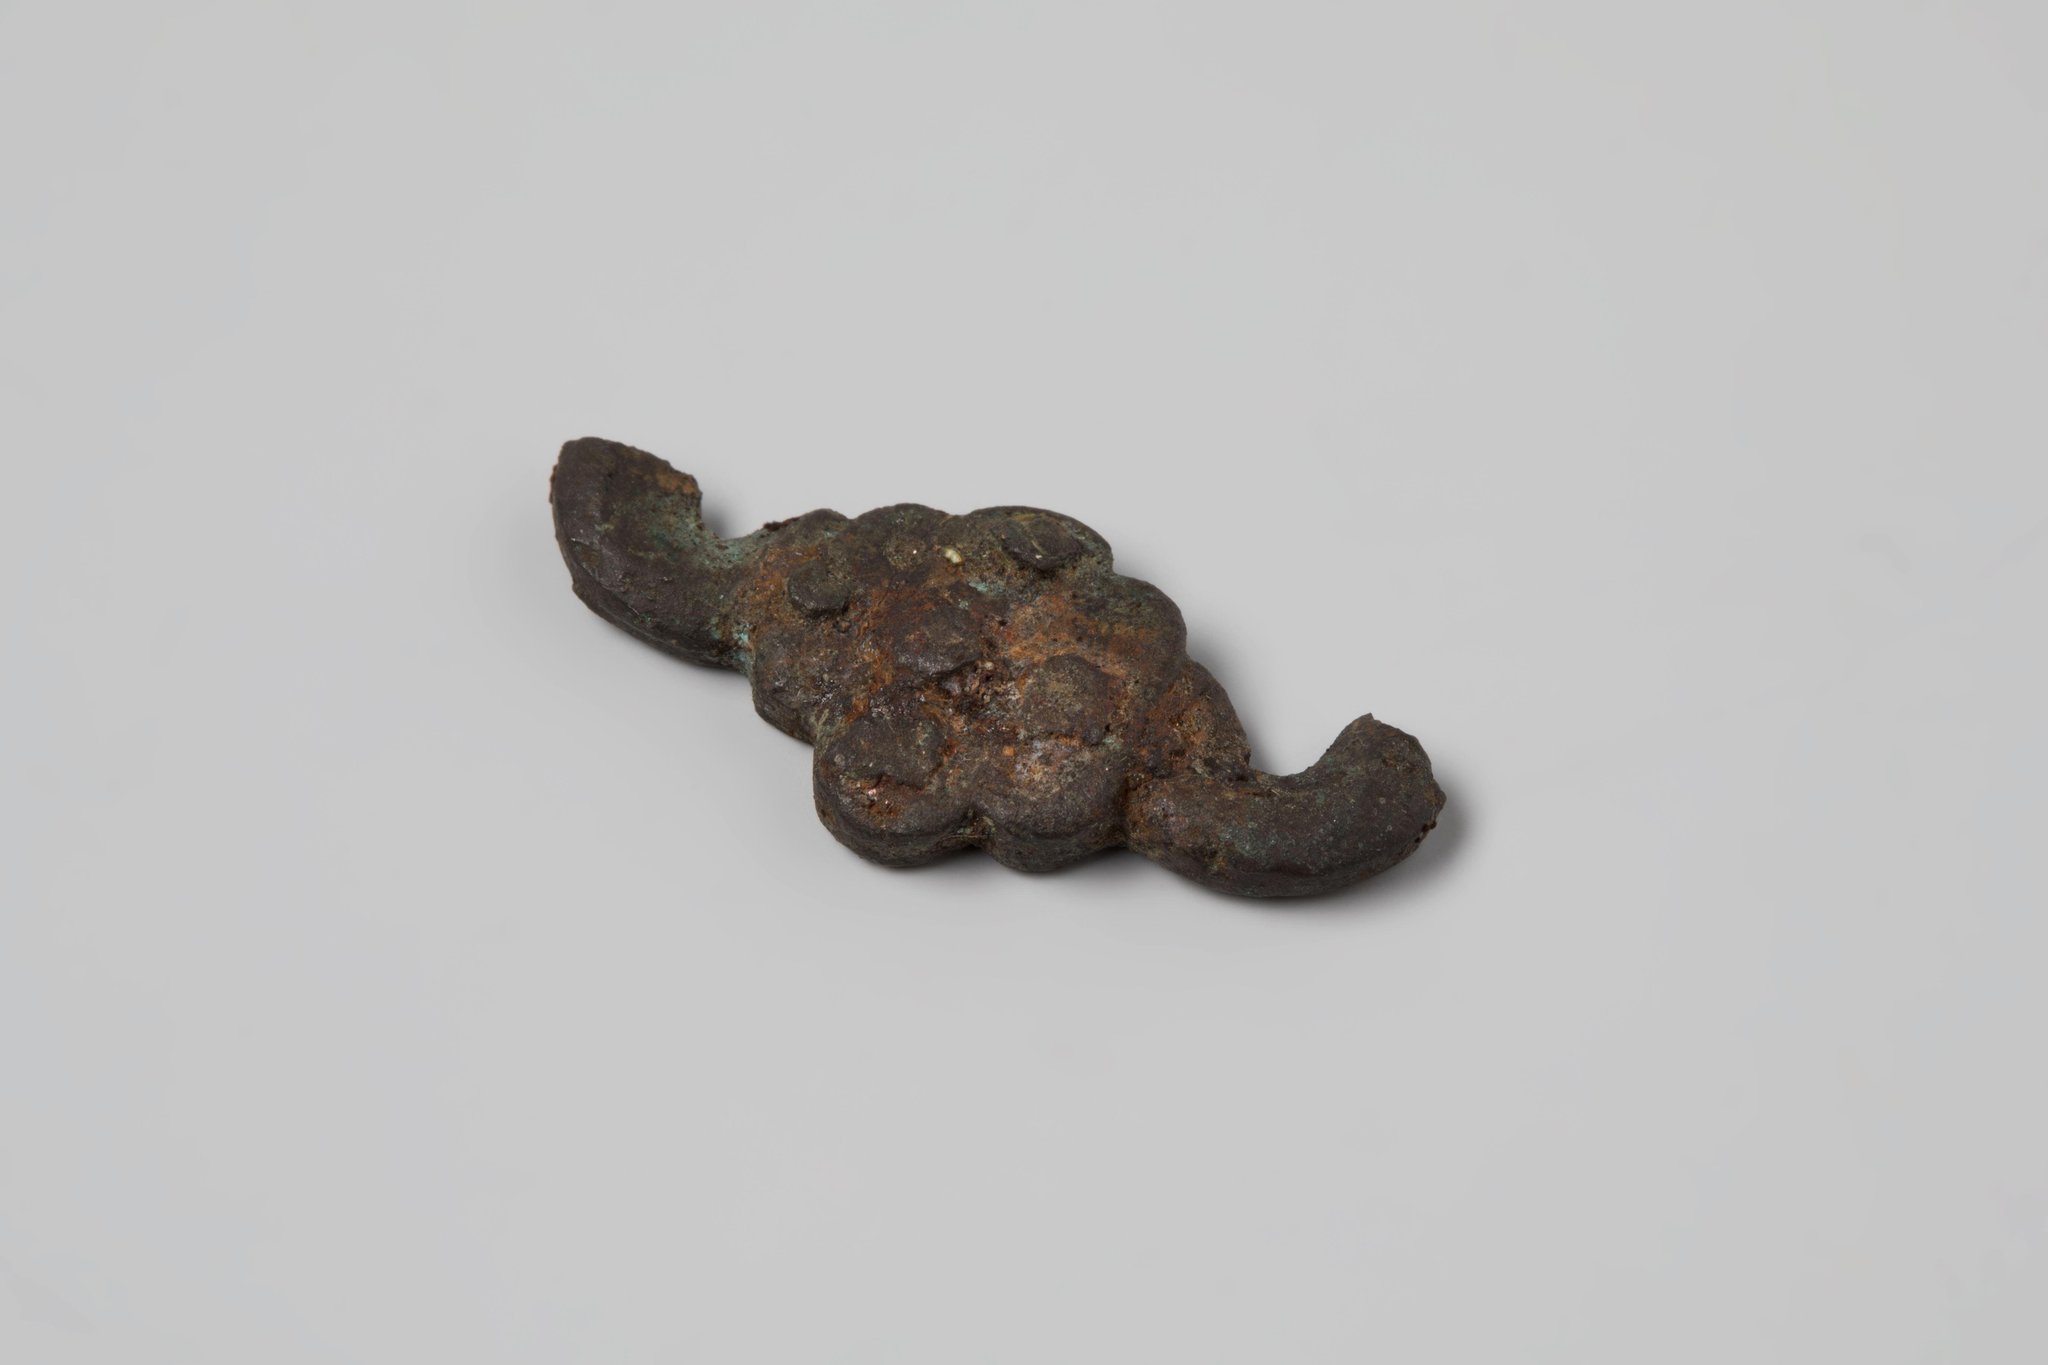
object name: beslag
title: Decoratief beslag uit het wrak van de Oost-Indiëvaarder Hollandia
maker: Anonymous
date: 1700-1743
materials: copper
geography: netherlands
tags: verenigde oostindische compagnie, hollandia (schip), annet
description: Fitting, decorative fitting or fragment; fragm, flat, circular with scrolling outline, 2 curved lateral extensions broken off, 5 rivets in central part.